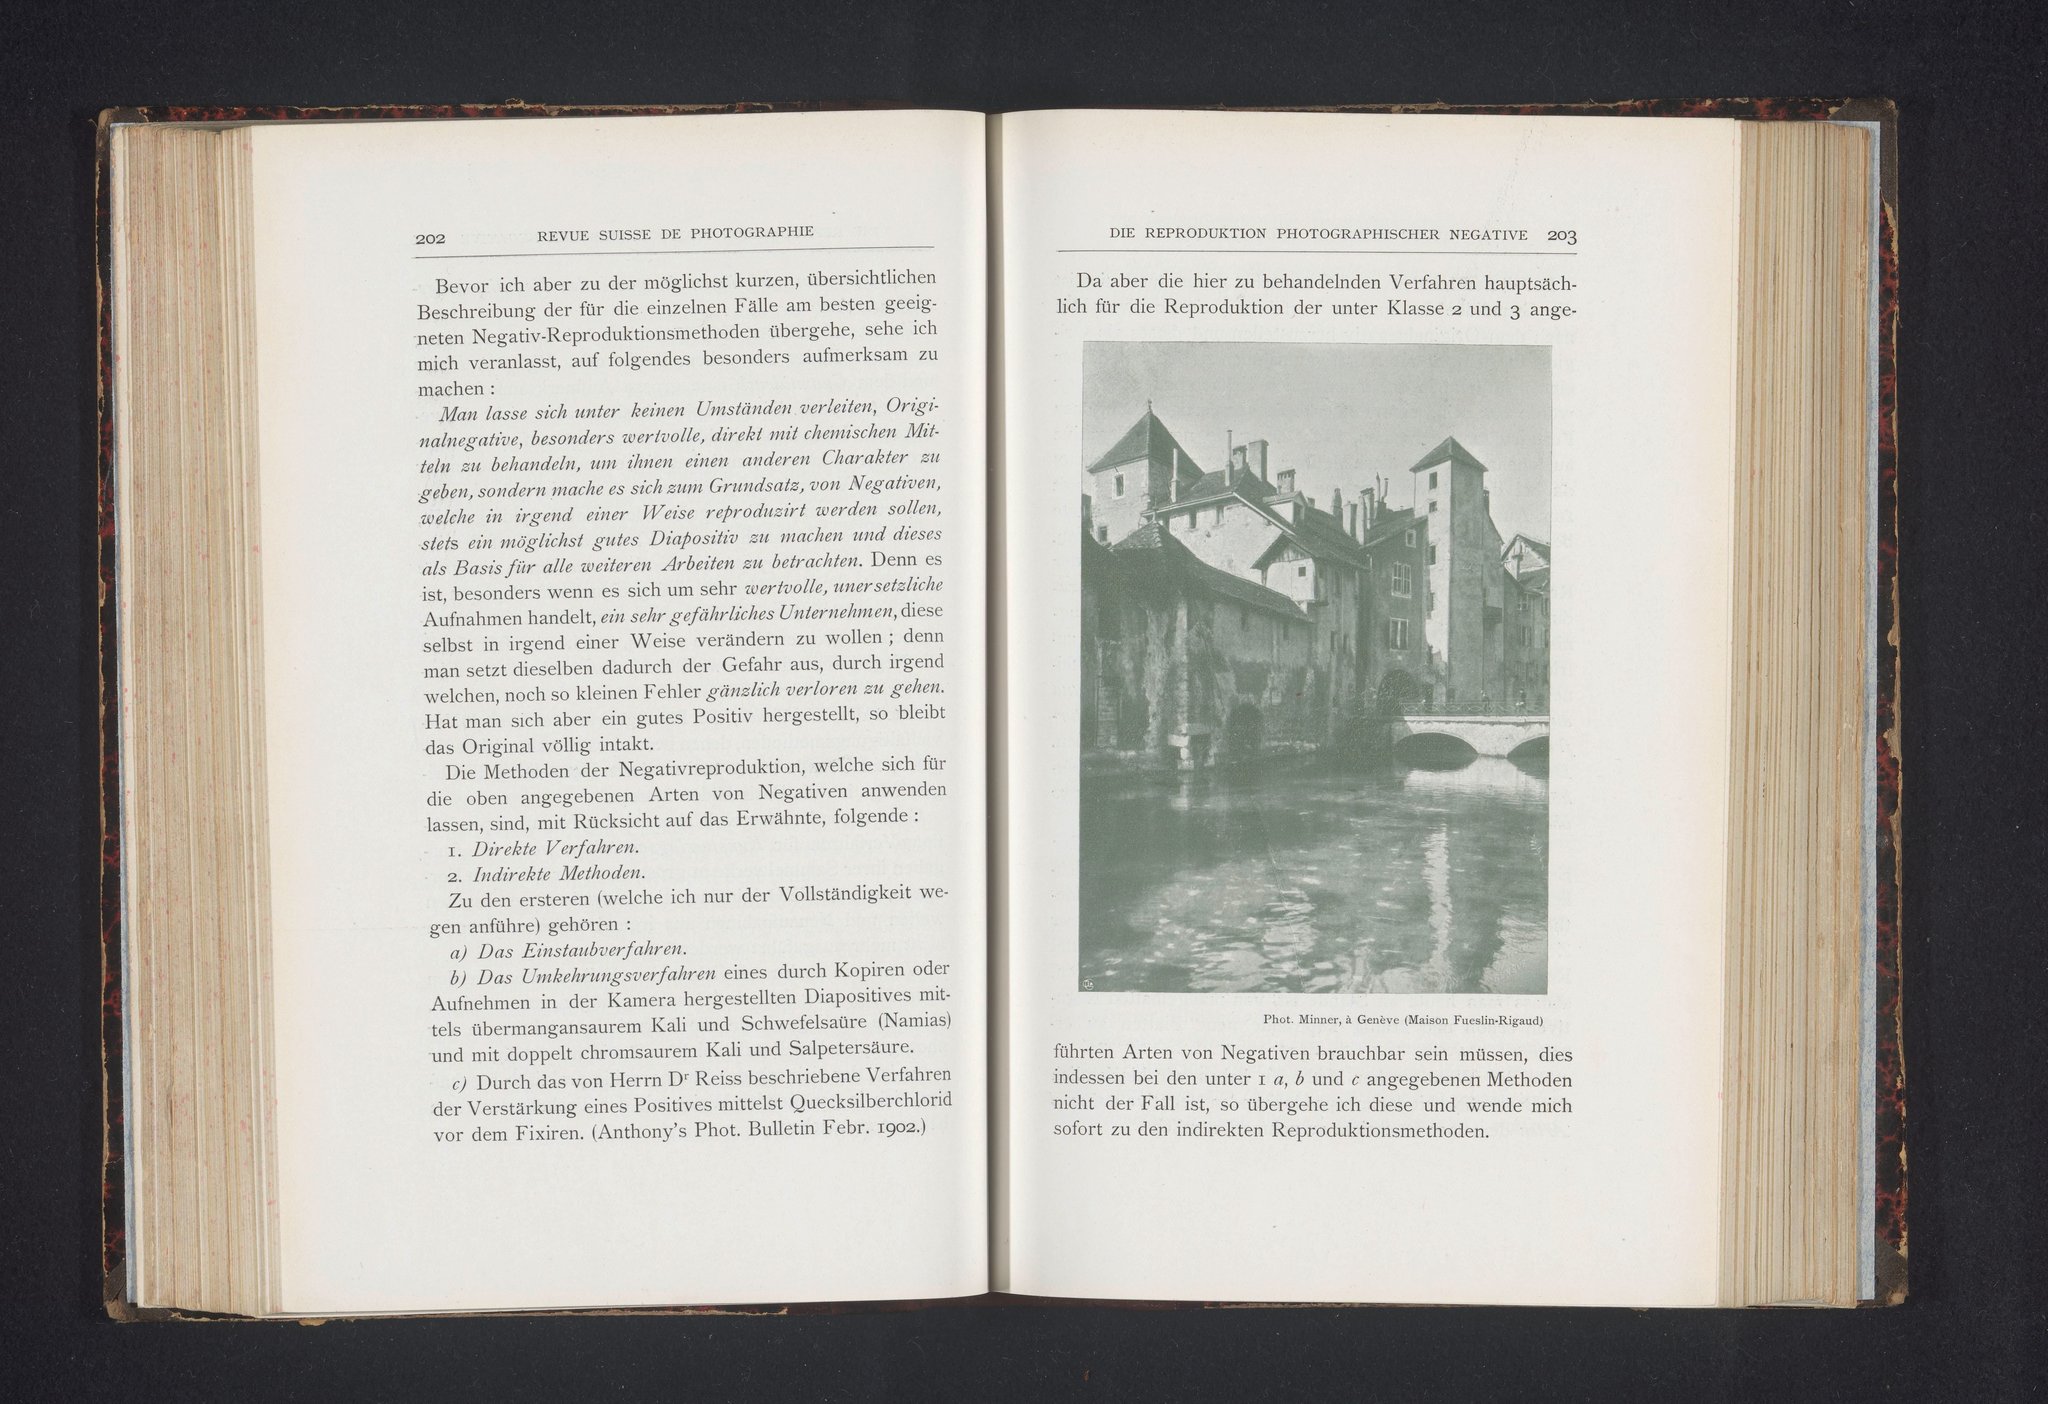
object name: page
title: Stadsgezicht met een rivier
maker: Anonymous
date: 1897-1902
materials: paper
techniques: autotype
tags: city-view in general; 'veduta', river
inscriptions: inscription: ‘Phot. Minner, à Genève (Maison Fueslin-Rigaud)’, monogram: ‘C. Cie’